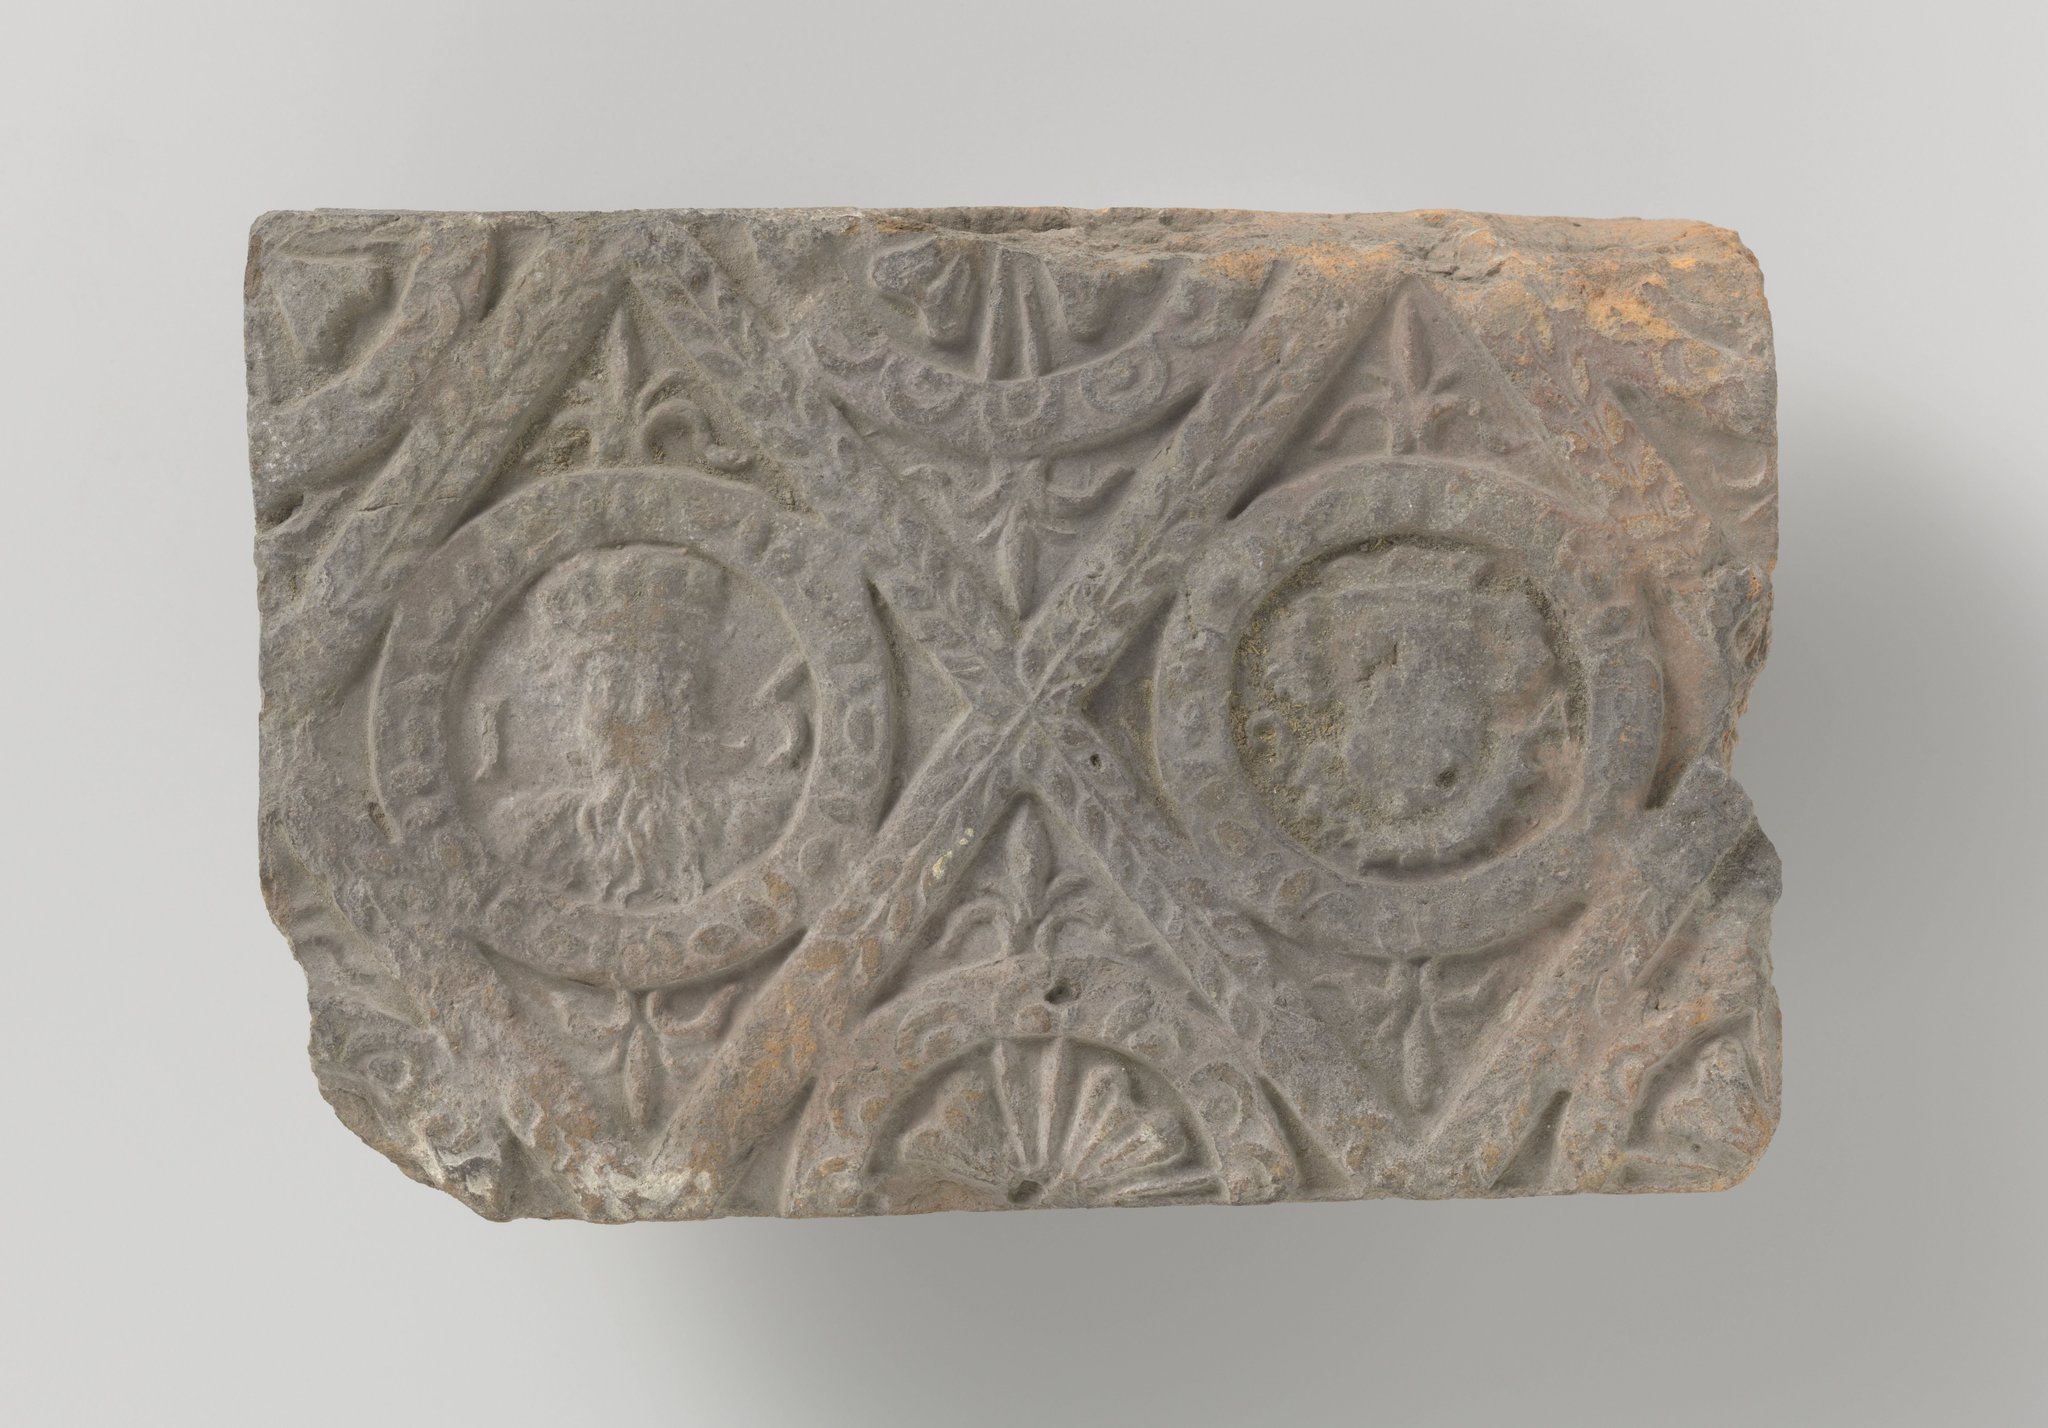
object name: hearthstone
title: Haardsteen met voorstelling van keizerskoppen, geplaatst in twee geprofileerde ruiten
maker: Anonymous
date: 1594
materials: earthenware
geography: southern netherlands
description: Haardsteen met voorstelling van keizerskoppen, geplaatst in twee geprofileerde ruiten en vergezeld van het jaartal 1594.